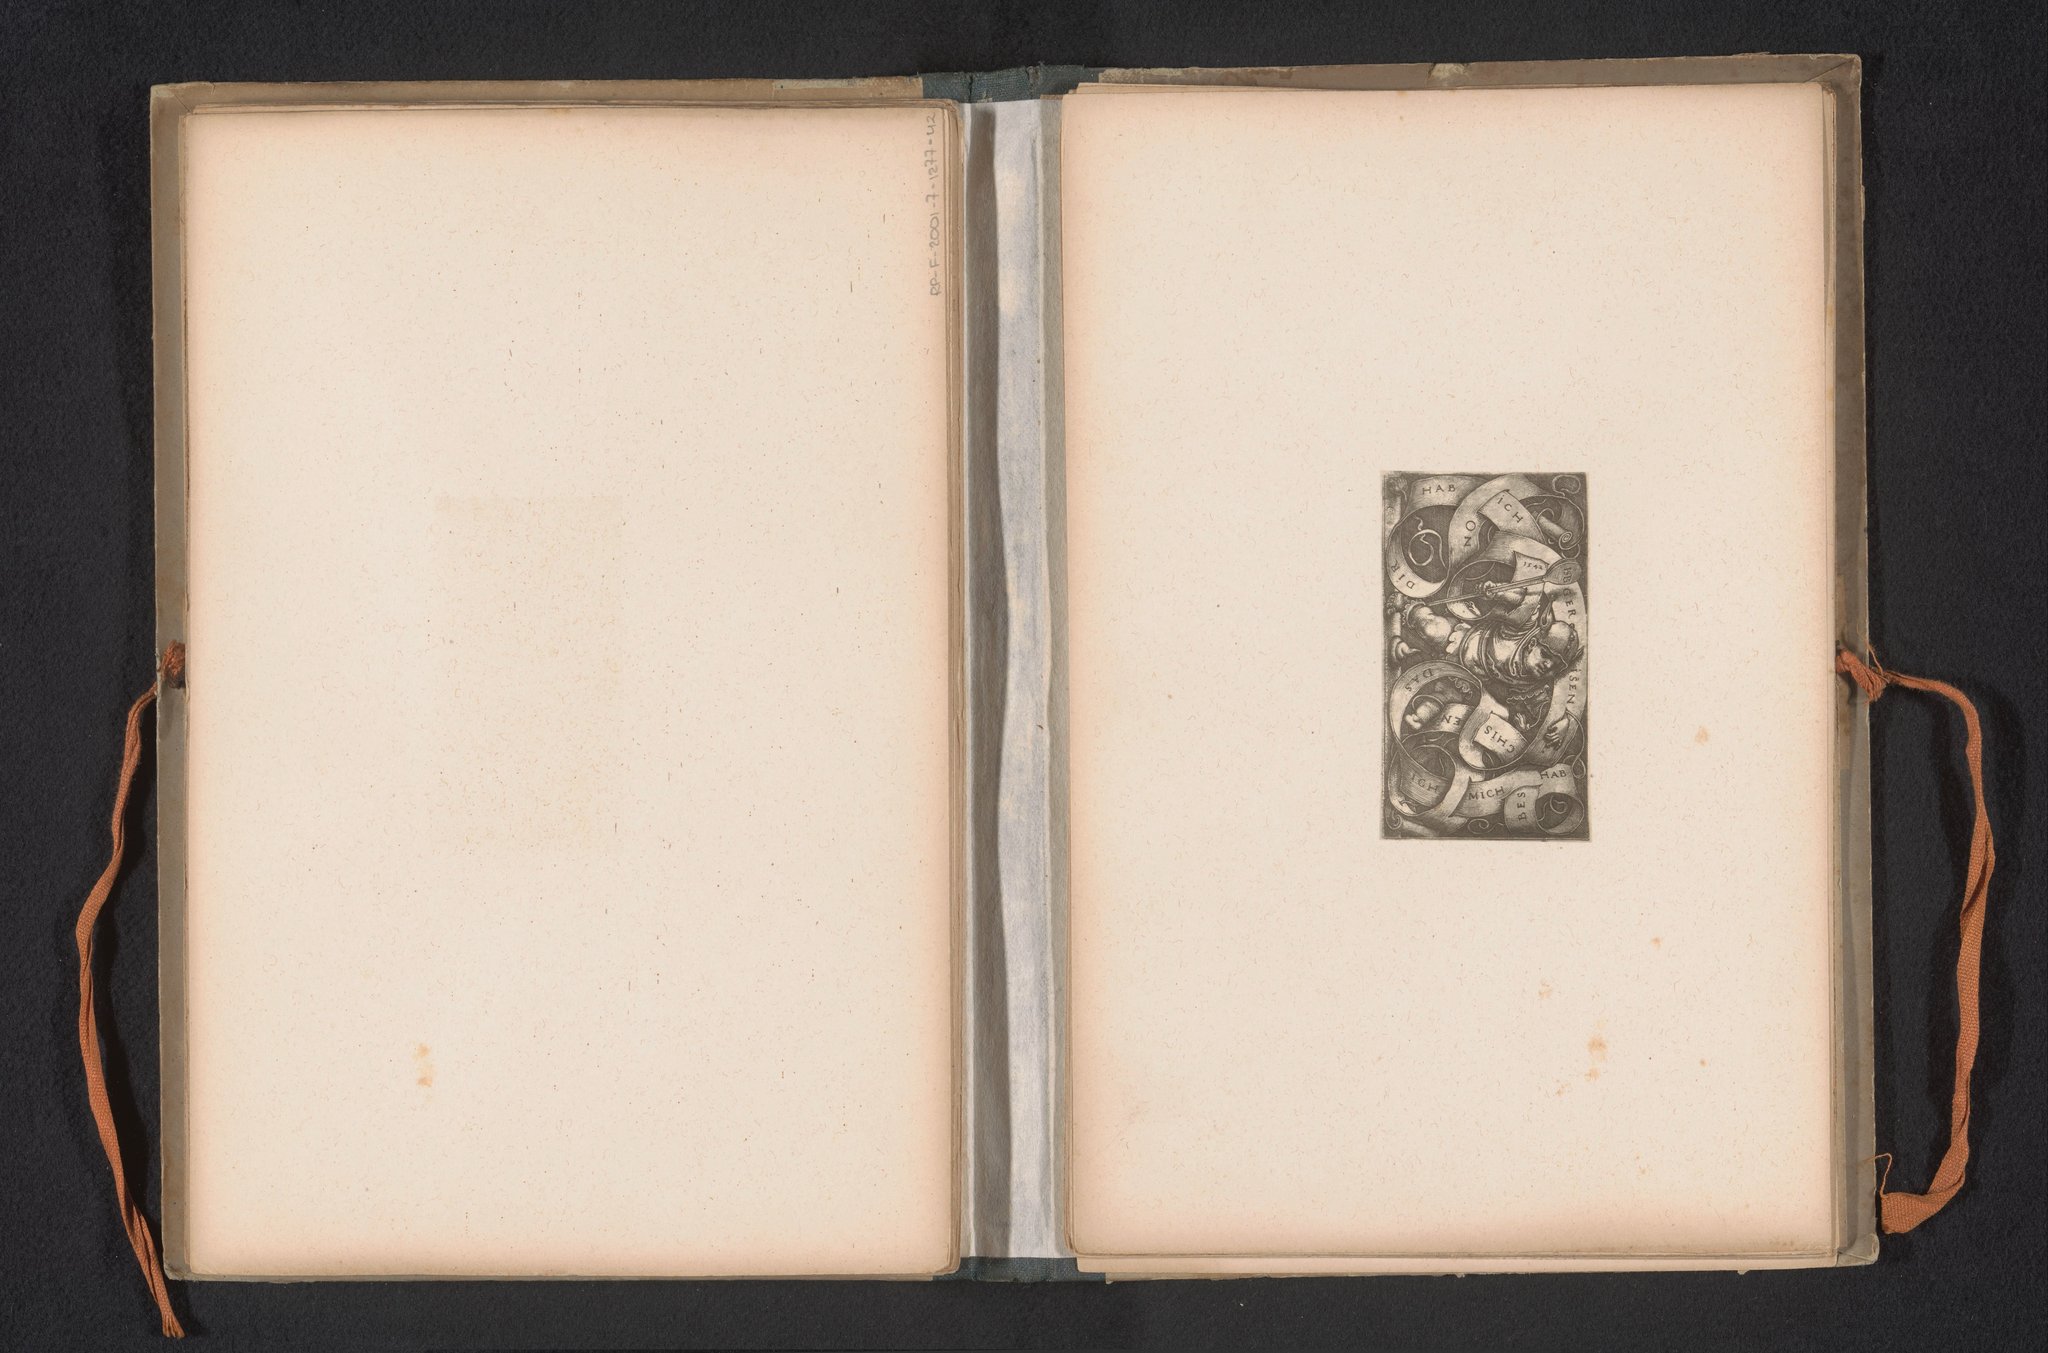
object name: photomechanical print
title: Reproductie van een prent van een lint met tekst en een cupido door Hans Sebald Beham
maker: hans sebald beham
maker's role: designer, draughtsman, print maker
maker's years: 1500-1550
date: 1866-1871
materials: paper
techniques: woodburytype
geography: brussels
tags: ribbon, scroll, banderole ~ ornament, cupids: 'amores', 'amoretti', 'putti'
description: Deze prent maakt deel uit van een omslag met 57 prenten op 54 bladen.